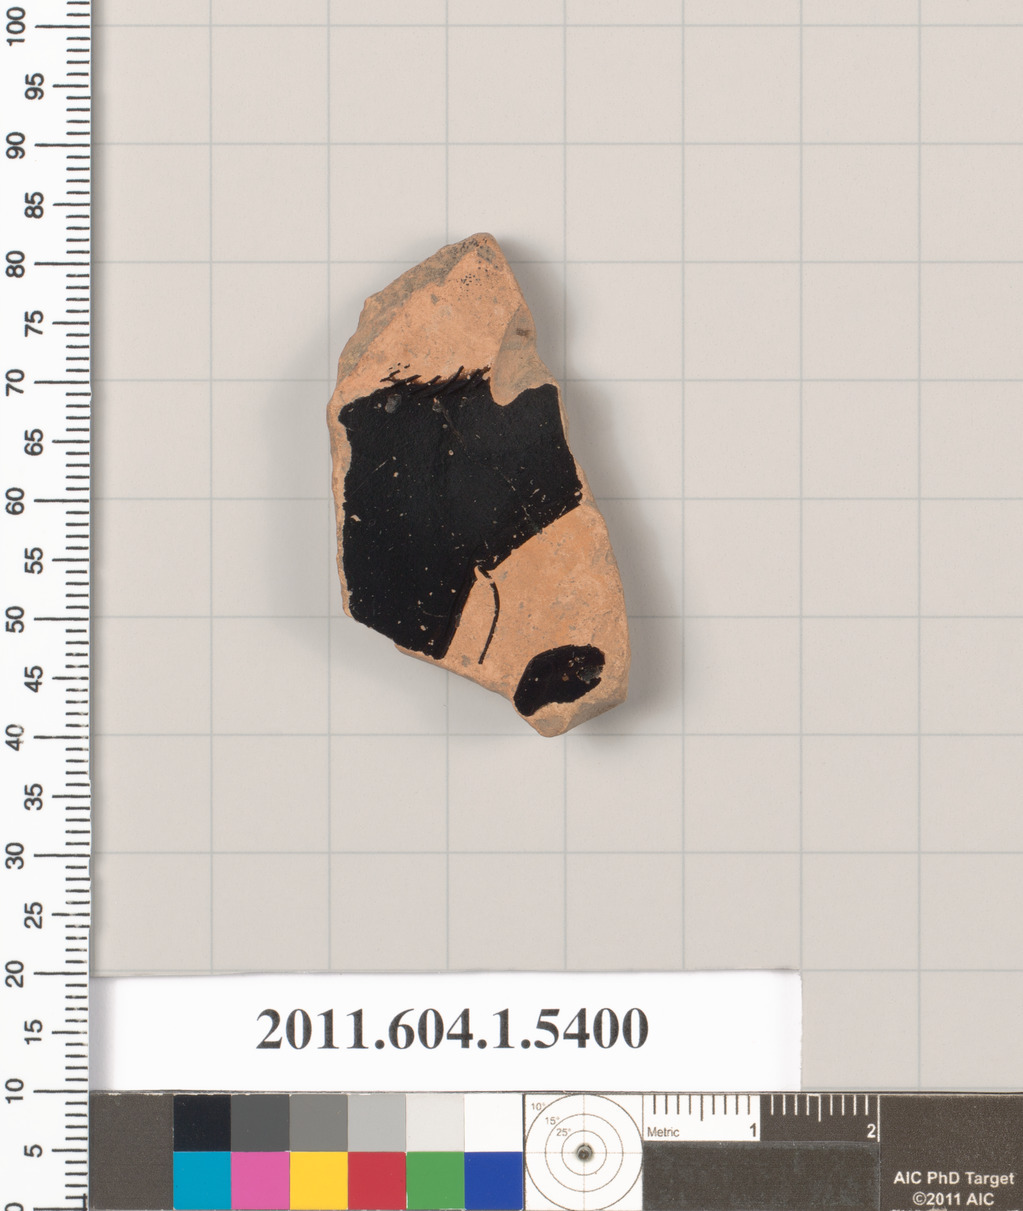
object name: kylix fragment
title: Terracotta fragment of a kylix (drinking cup)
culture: greek, attic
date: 500-480 BCE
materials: terracotta